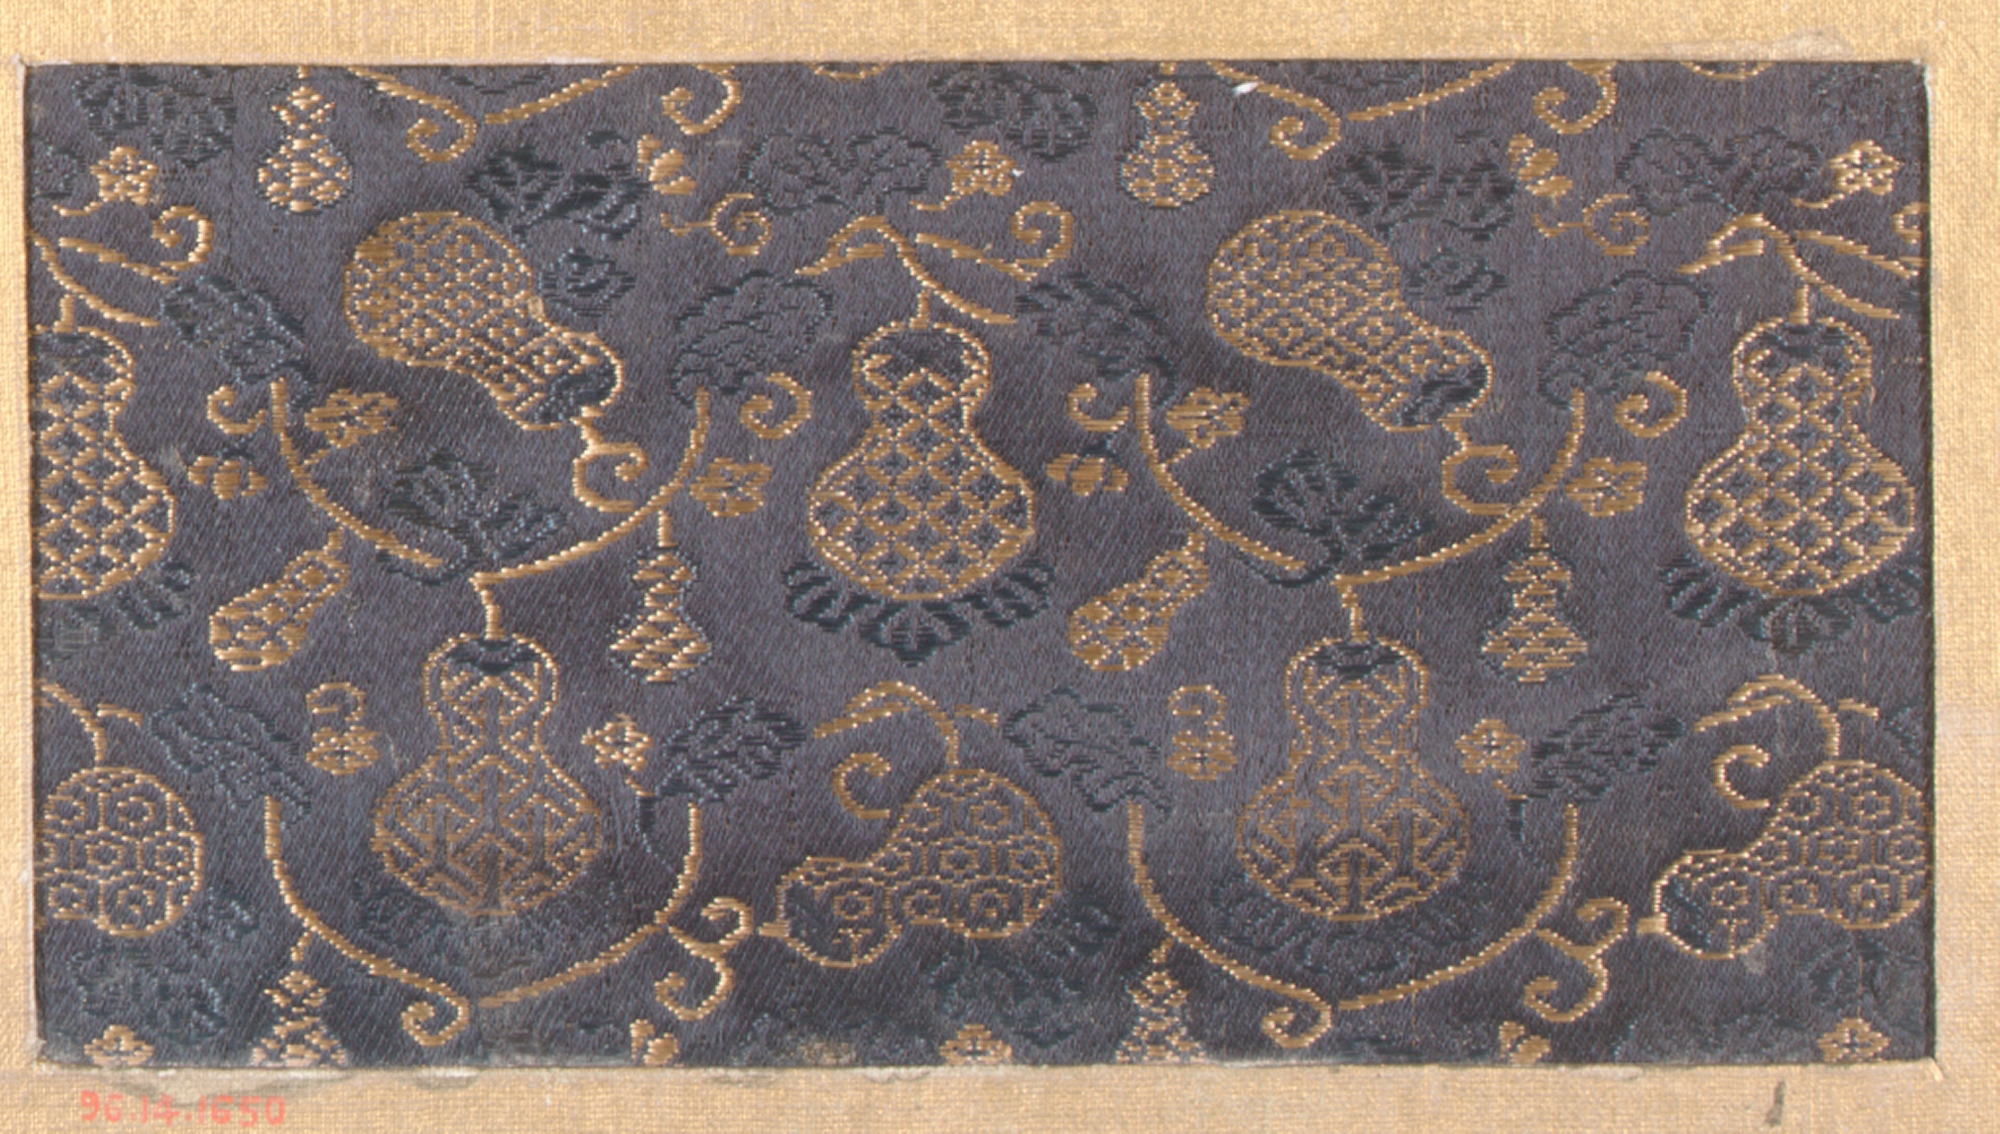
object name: piece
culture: japanese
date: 1701-1900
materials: silk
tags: gourds